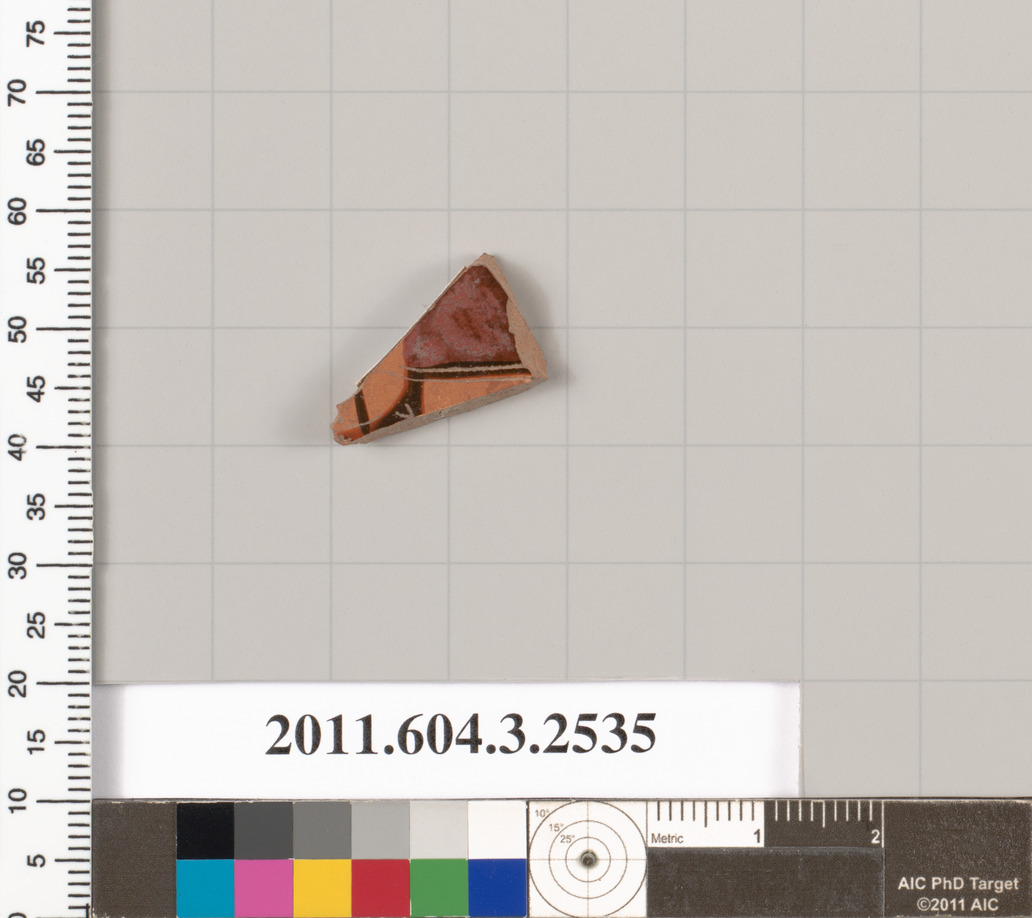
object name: kylix fragment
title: Terracotta fragment of a kylix: Siana cup (drinking cup)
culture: greek, attic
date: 550-526 BCE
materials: terracotta